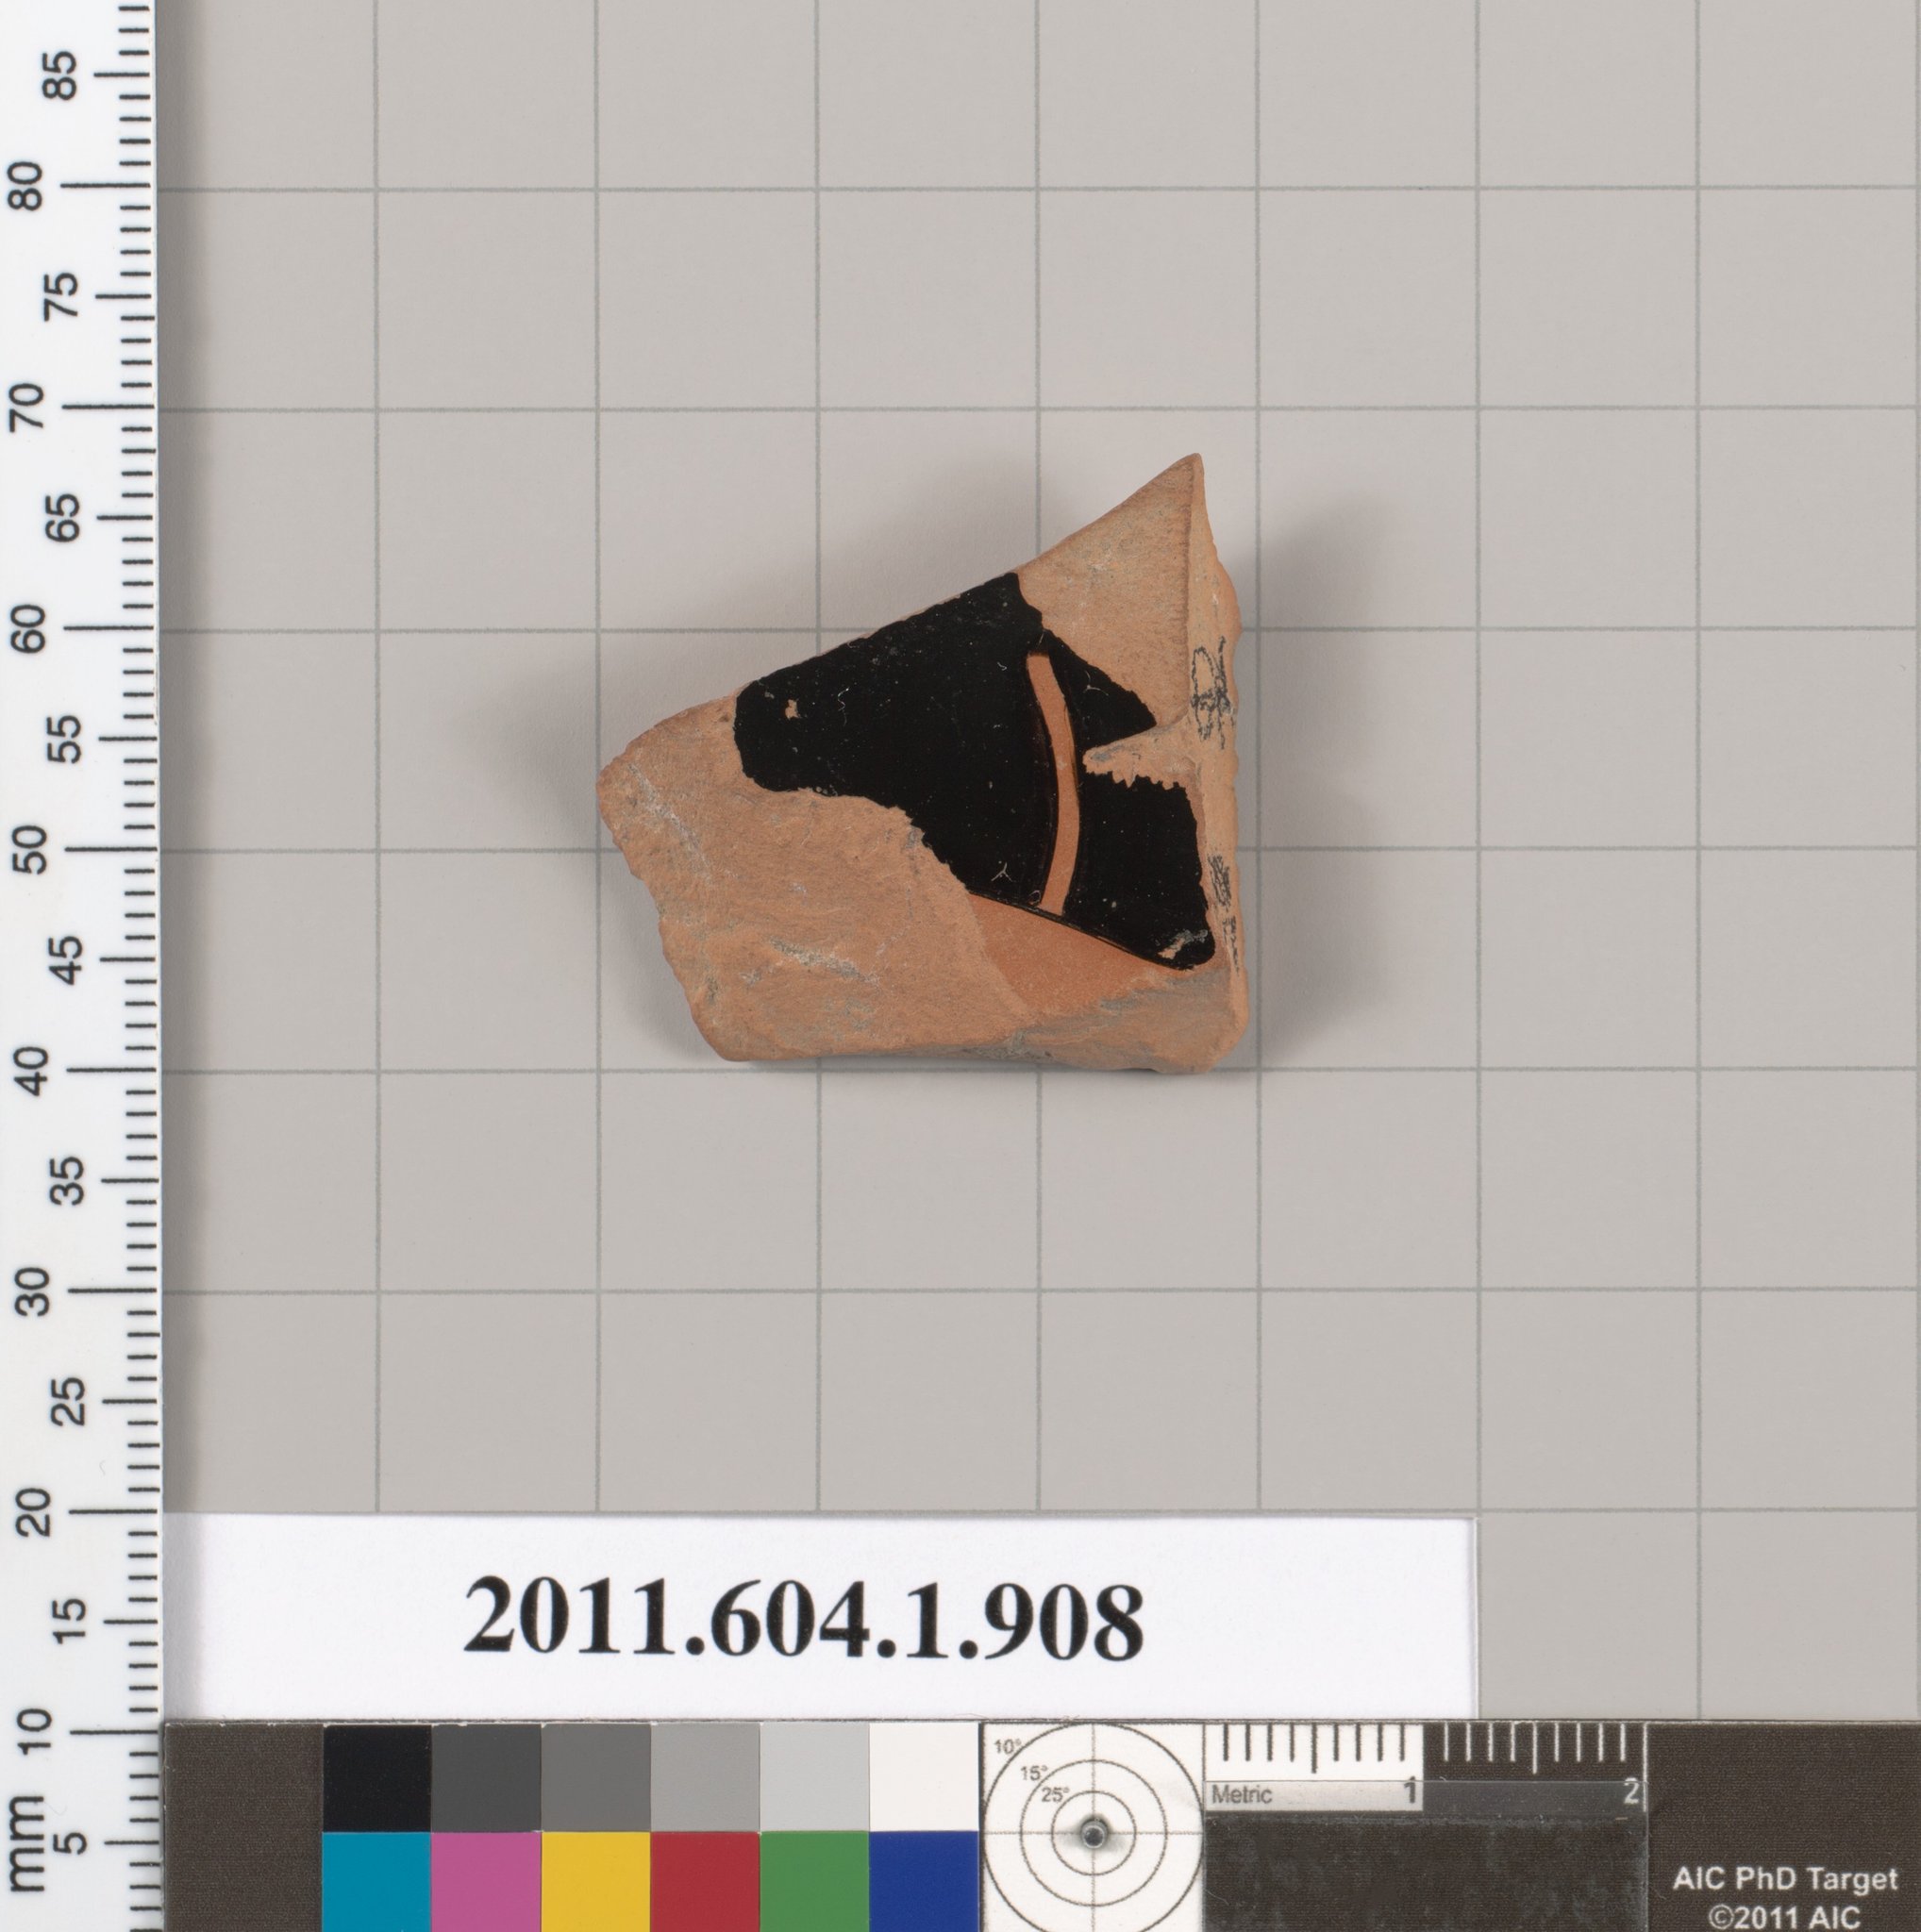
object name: kylix fragment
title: Terracotta fragment of a kylix (drinking cup)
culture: greek, attic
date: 475-451 BCE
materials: terracotta